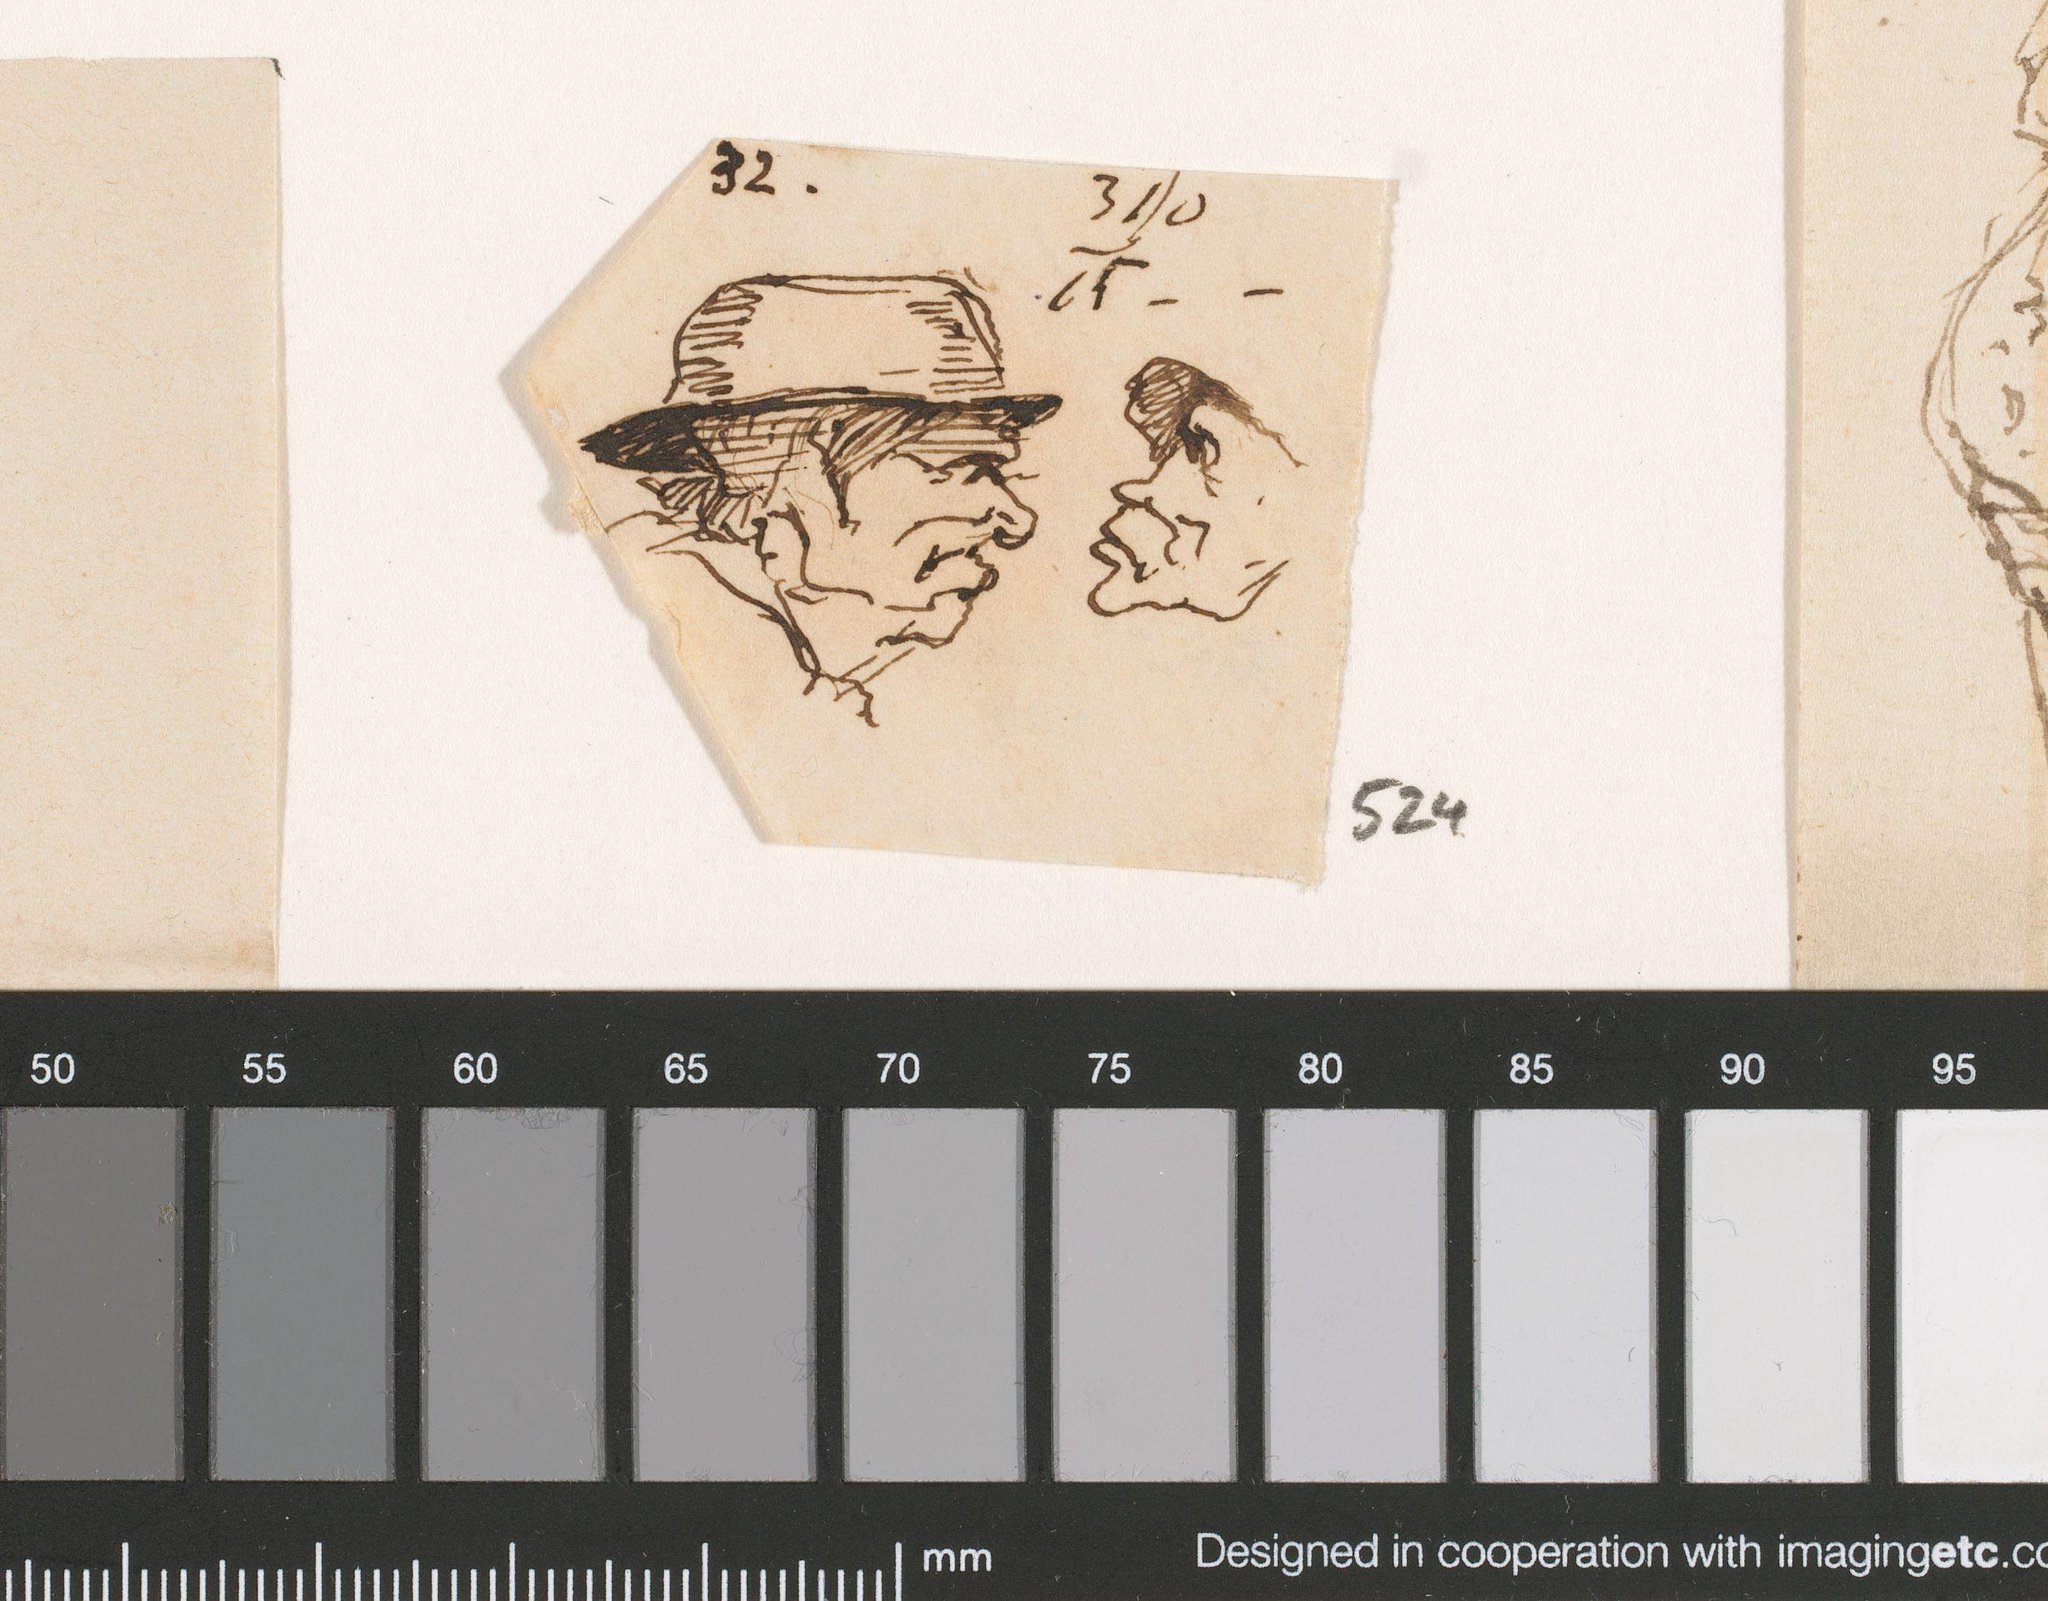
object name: drawing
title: Twee koppen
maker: johannes tavenraat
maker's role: draughtsman, painter, print maker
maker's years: 1809-1881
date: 1840-1880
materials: ink, paper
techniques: pen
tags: caricatures (human types)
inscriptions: collector's mark: Lugt 2228